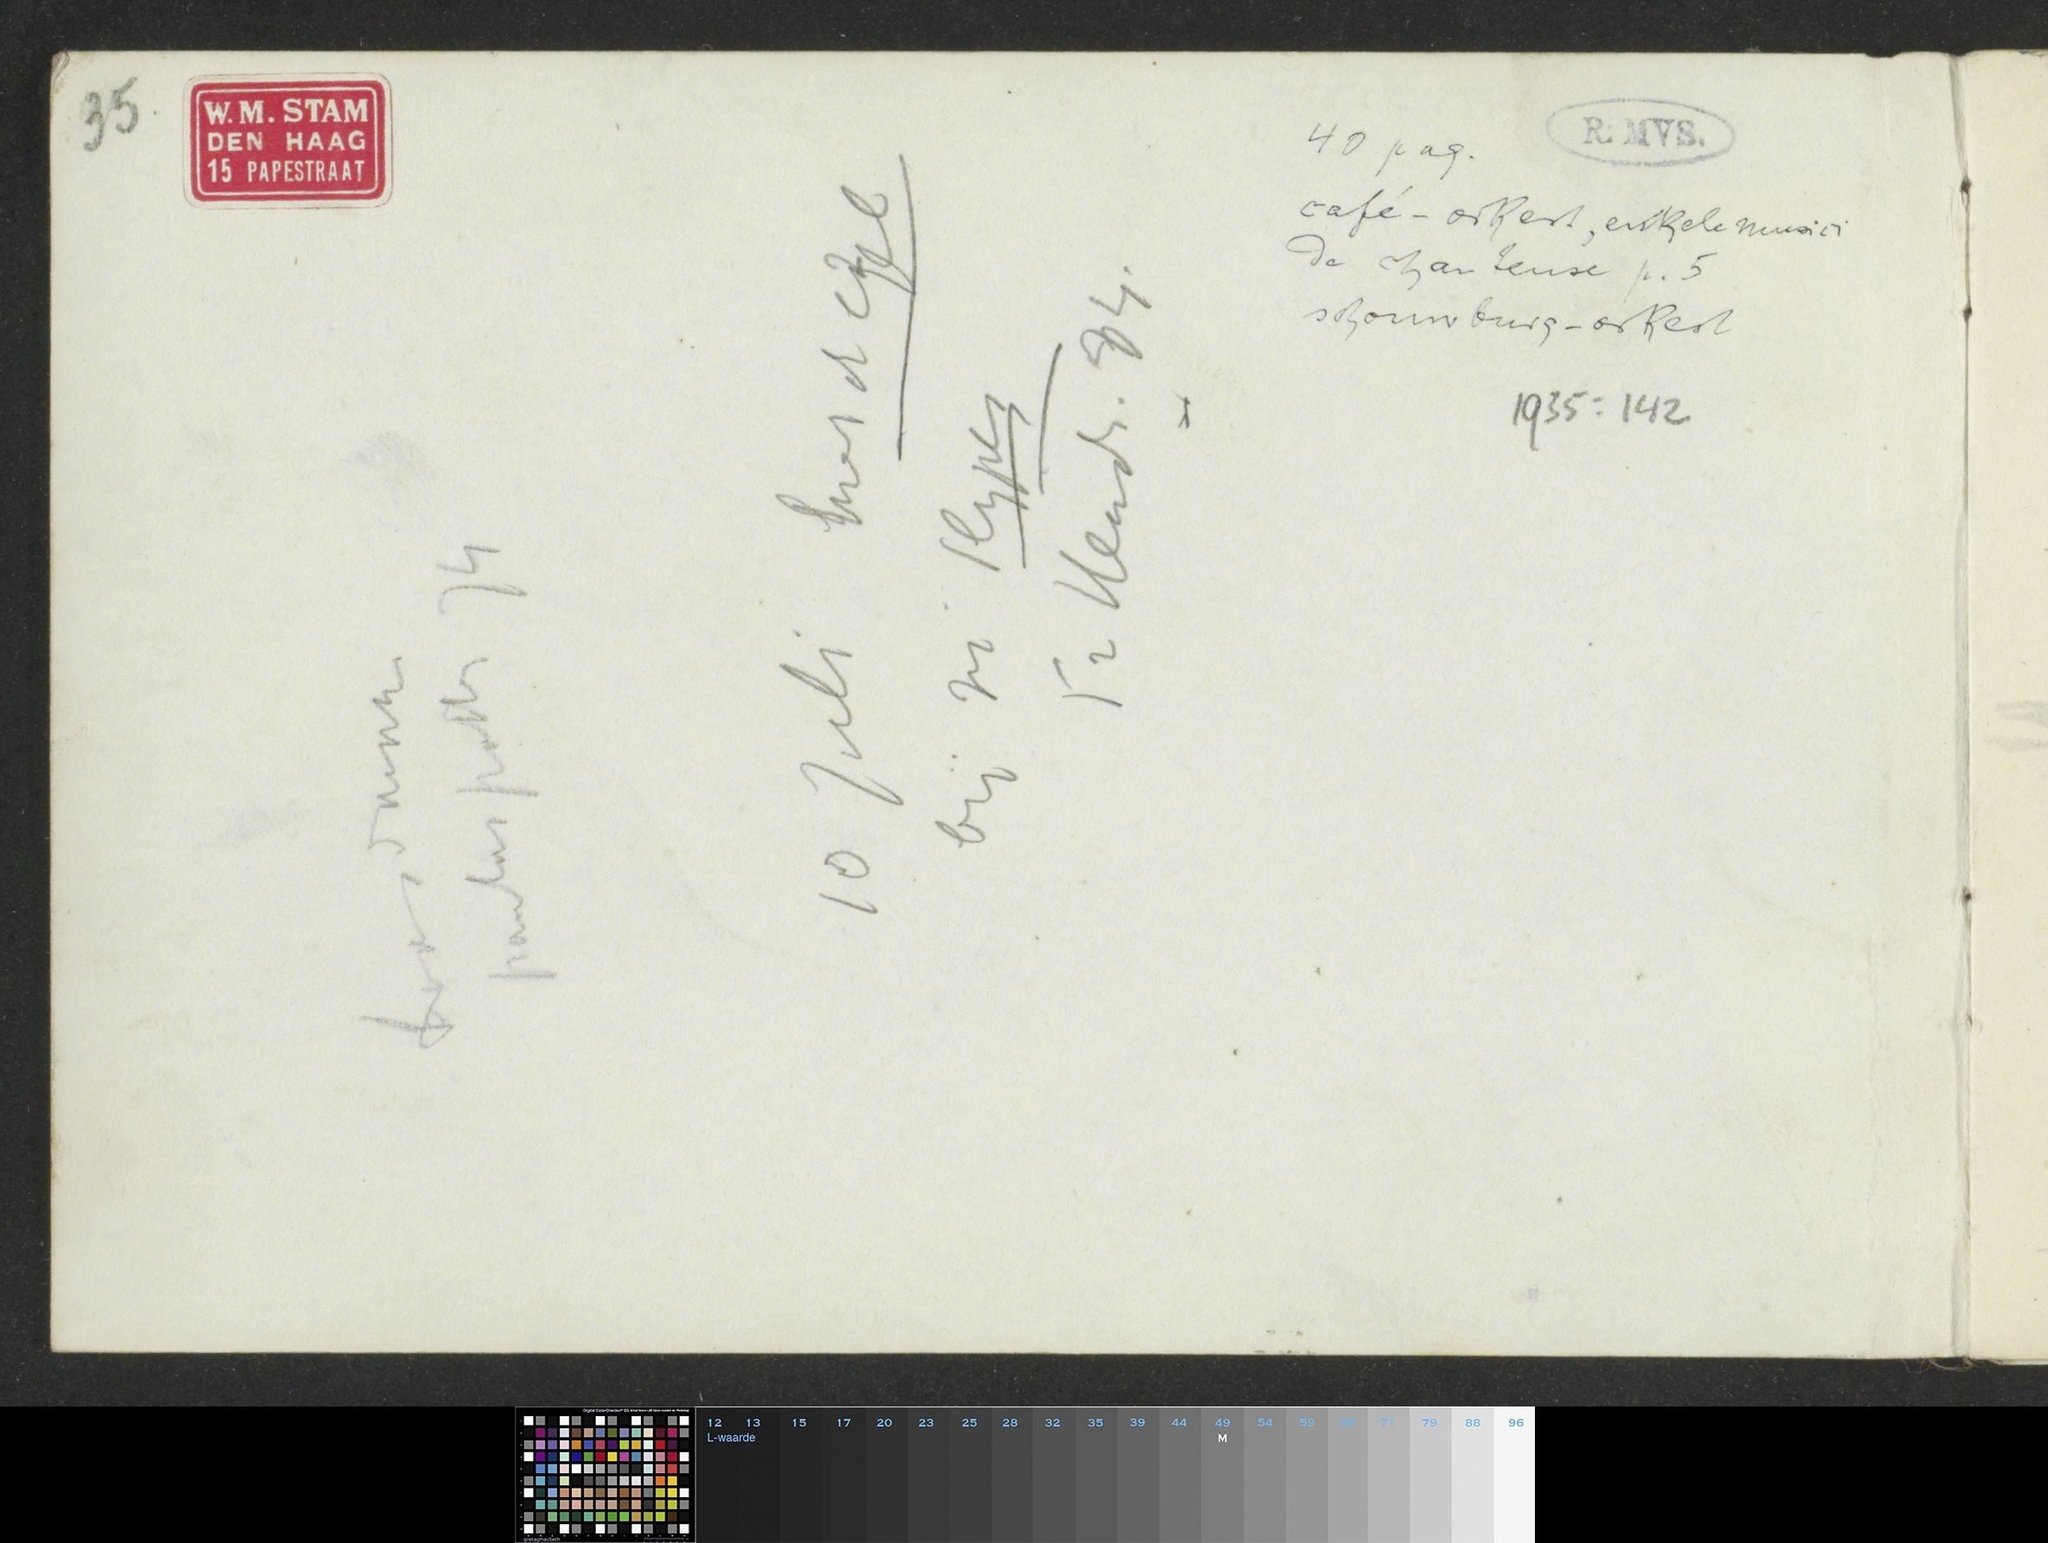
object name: sketchbook leaf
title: Annotaties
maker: isaac israels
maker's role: draughtsman, painter, print maker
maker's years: 1865-1934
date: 1875-1934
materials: paper, pencil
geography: the hague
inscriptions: collector's mark: Lugt 2228, annotation: ‘[...] / Paulus Potter 74 / 10 Juli met de ezel / bij [...] Slijpes / 52 Hendr. 84’, retailer's mark: ‘W.M. Stam / Den Haag / 15 Papestraat’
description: Schutblad A, voorste schutblad, uit schetsboek LXI met 20 bladen.